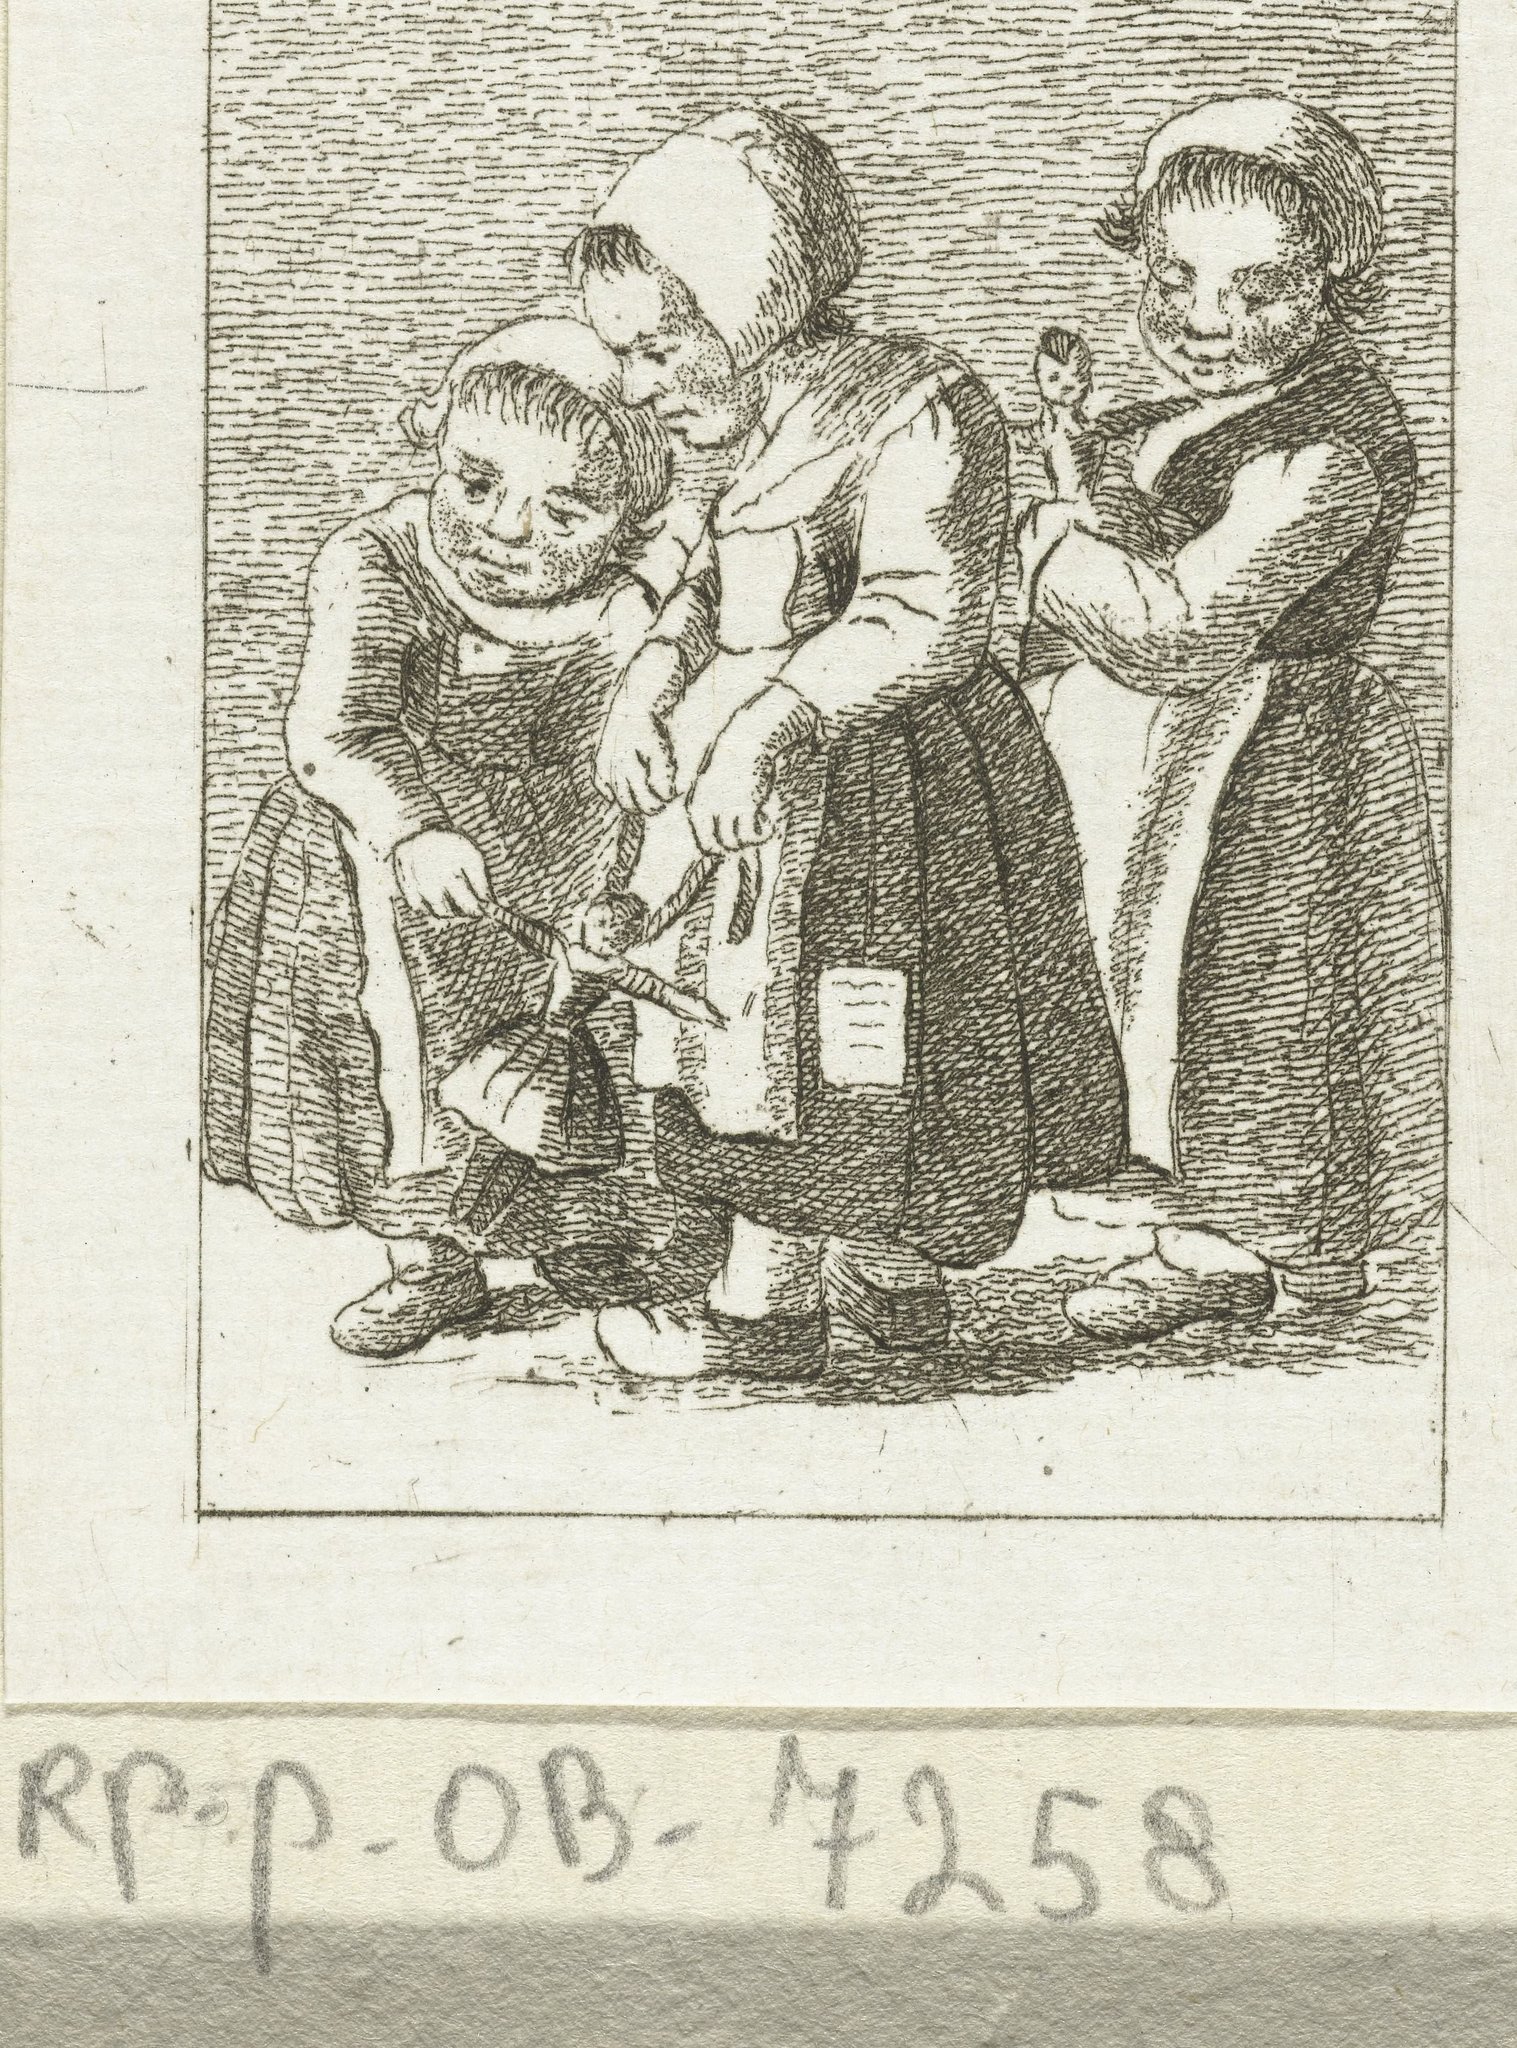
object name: print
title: Drie meisjes met poppen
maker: pieter de mare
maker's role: print maker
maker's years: 1758-1796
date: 1779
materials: paper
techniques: etching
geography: leiden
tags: (playing with) dolls, sisters (second degree family relationships)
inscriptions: collector's mark: Lugt 2228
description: Drie meisjes spelen met poppen. Een meisje houdt een pop in haar handen. Naast haar spelen de andere twee meisjes met een pop.